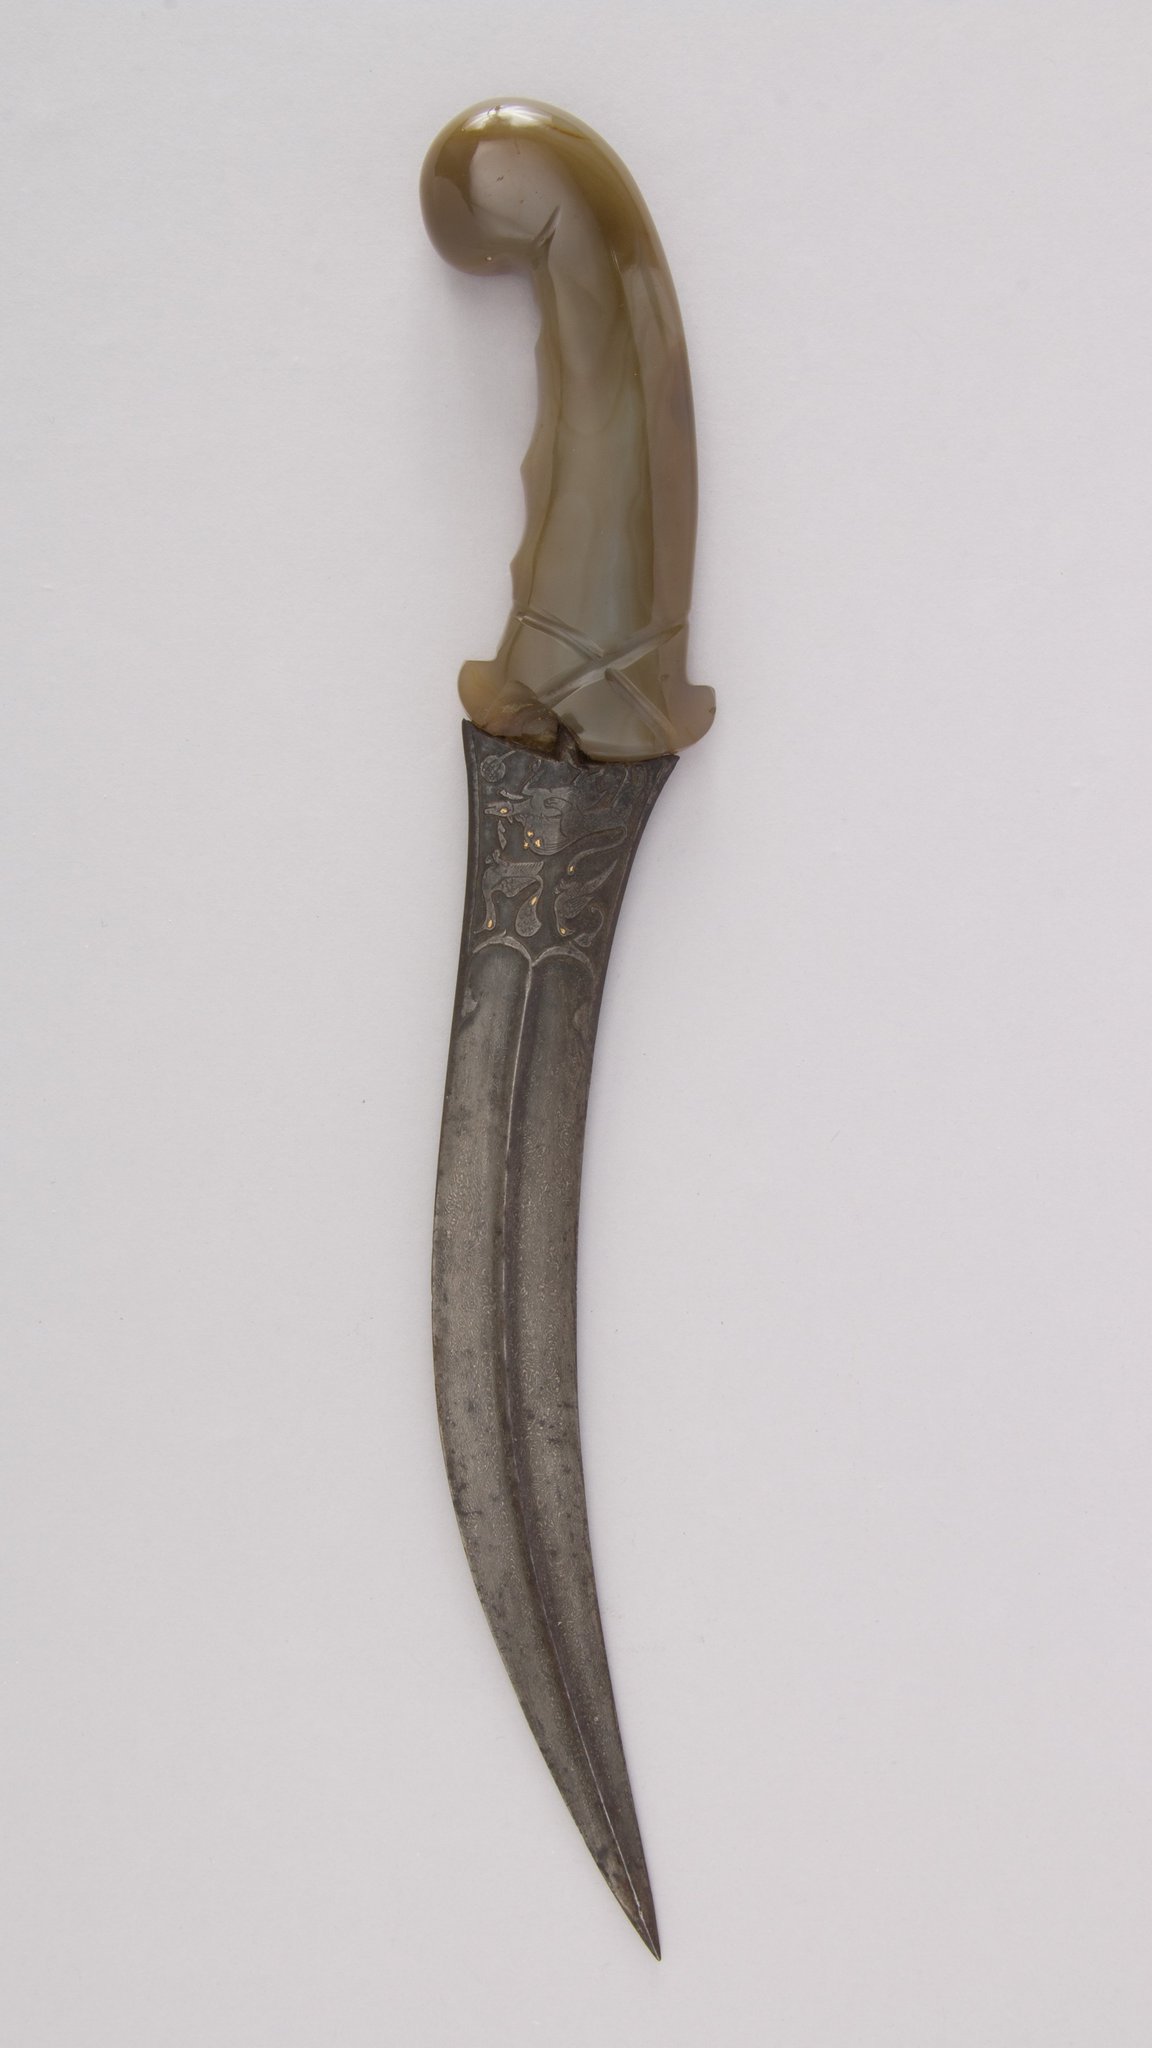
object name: dagger jambiya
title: Dagger (Jambiya)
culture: persian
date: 1701-1900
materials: stone, steel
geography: iran